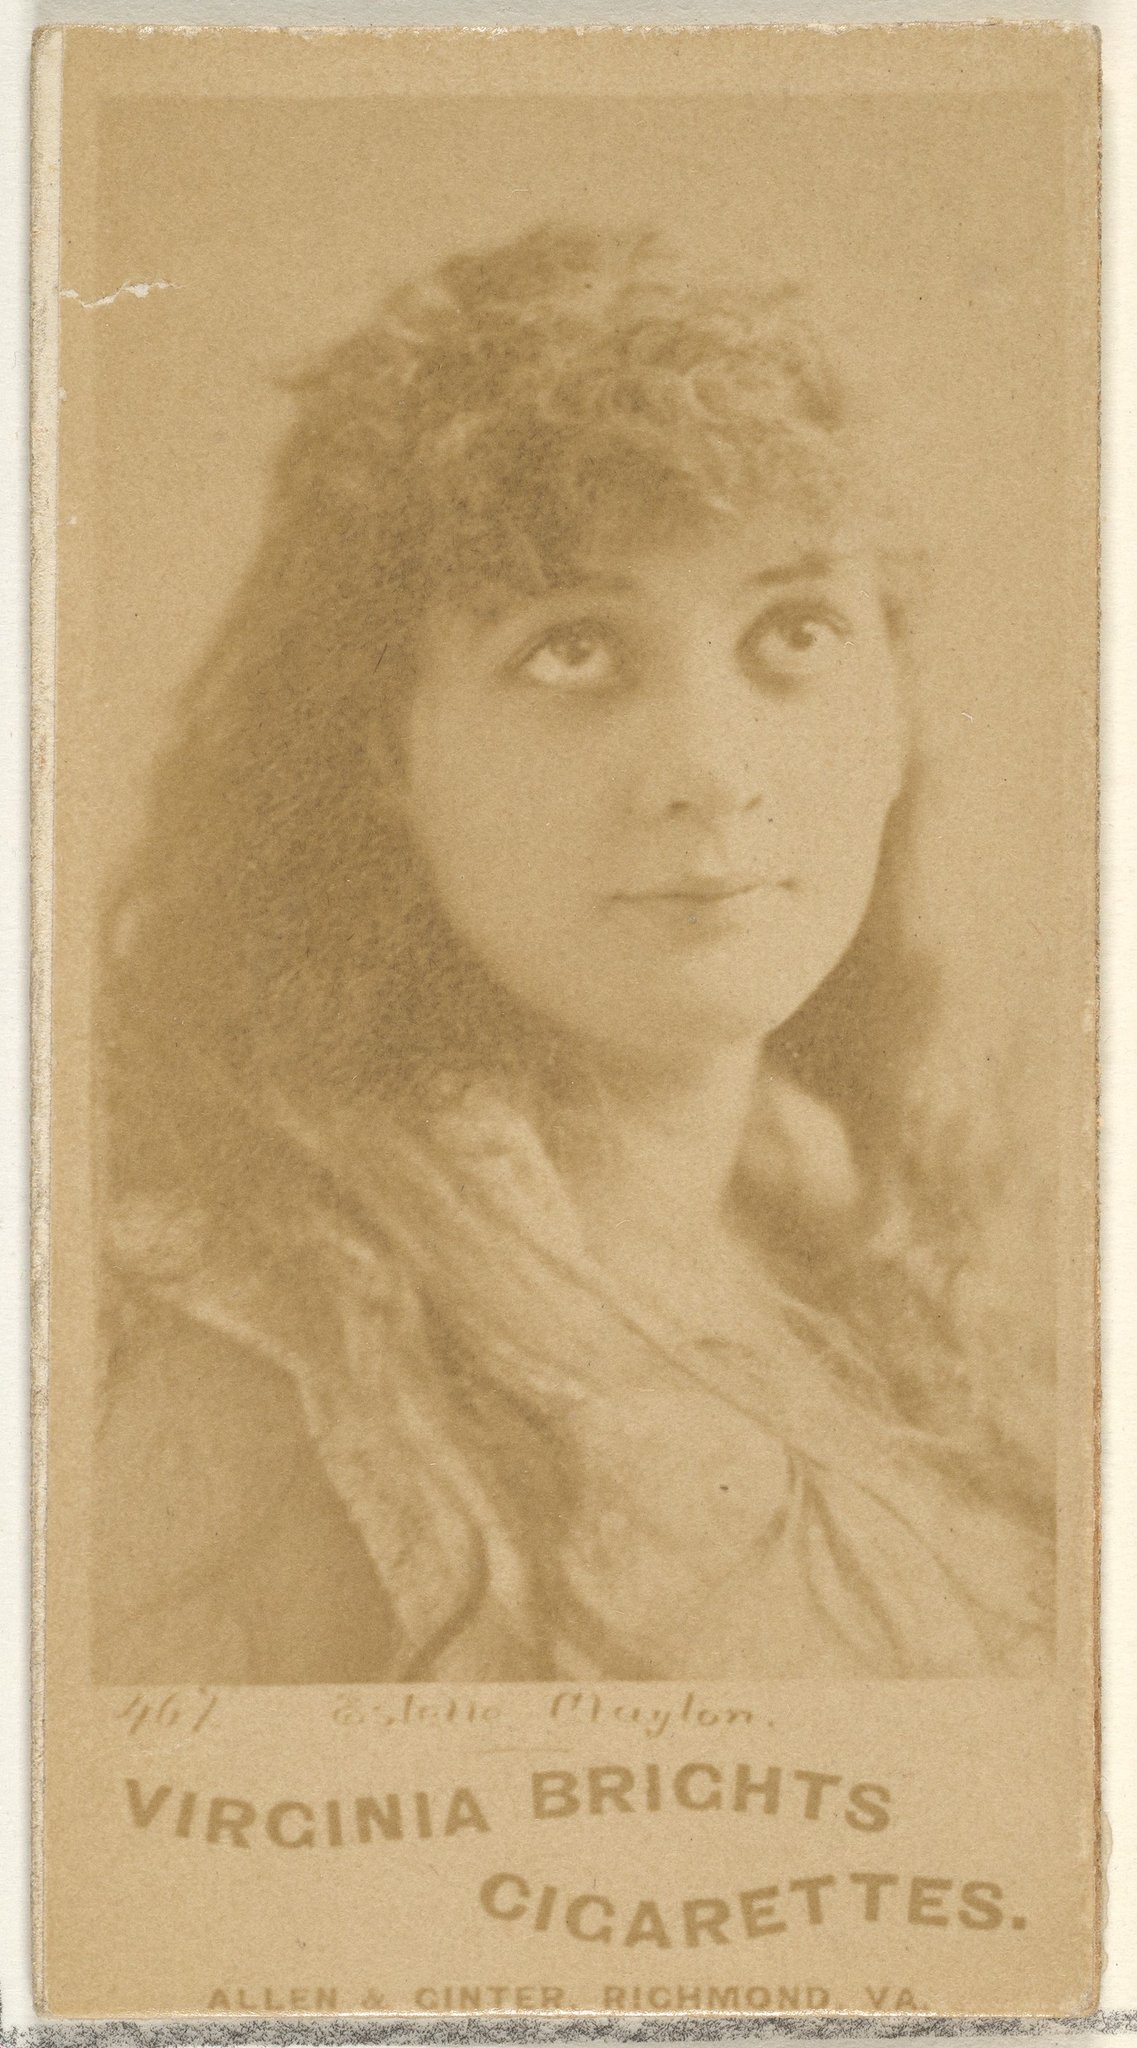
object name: photograph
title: Card 467, Estelle Clayton, from the Actors and Actresses series (N45, Type 1) for Virginia Brights Cigarettes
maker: allen & ginter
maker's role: publisher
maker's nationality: american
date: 1888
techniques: albumen silver print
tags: portraits,women,actresses